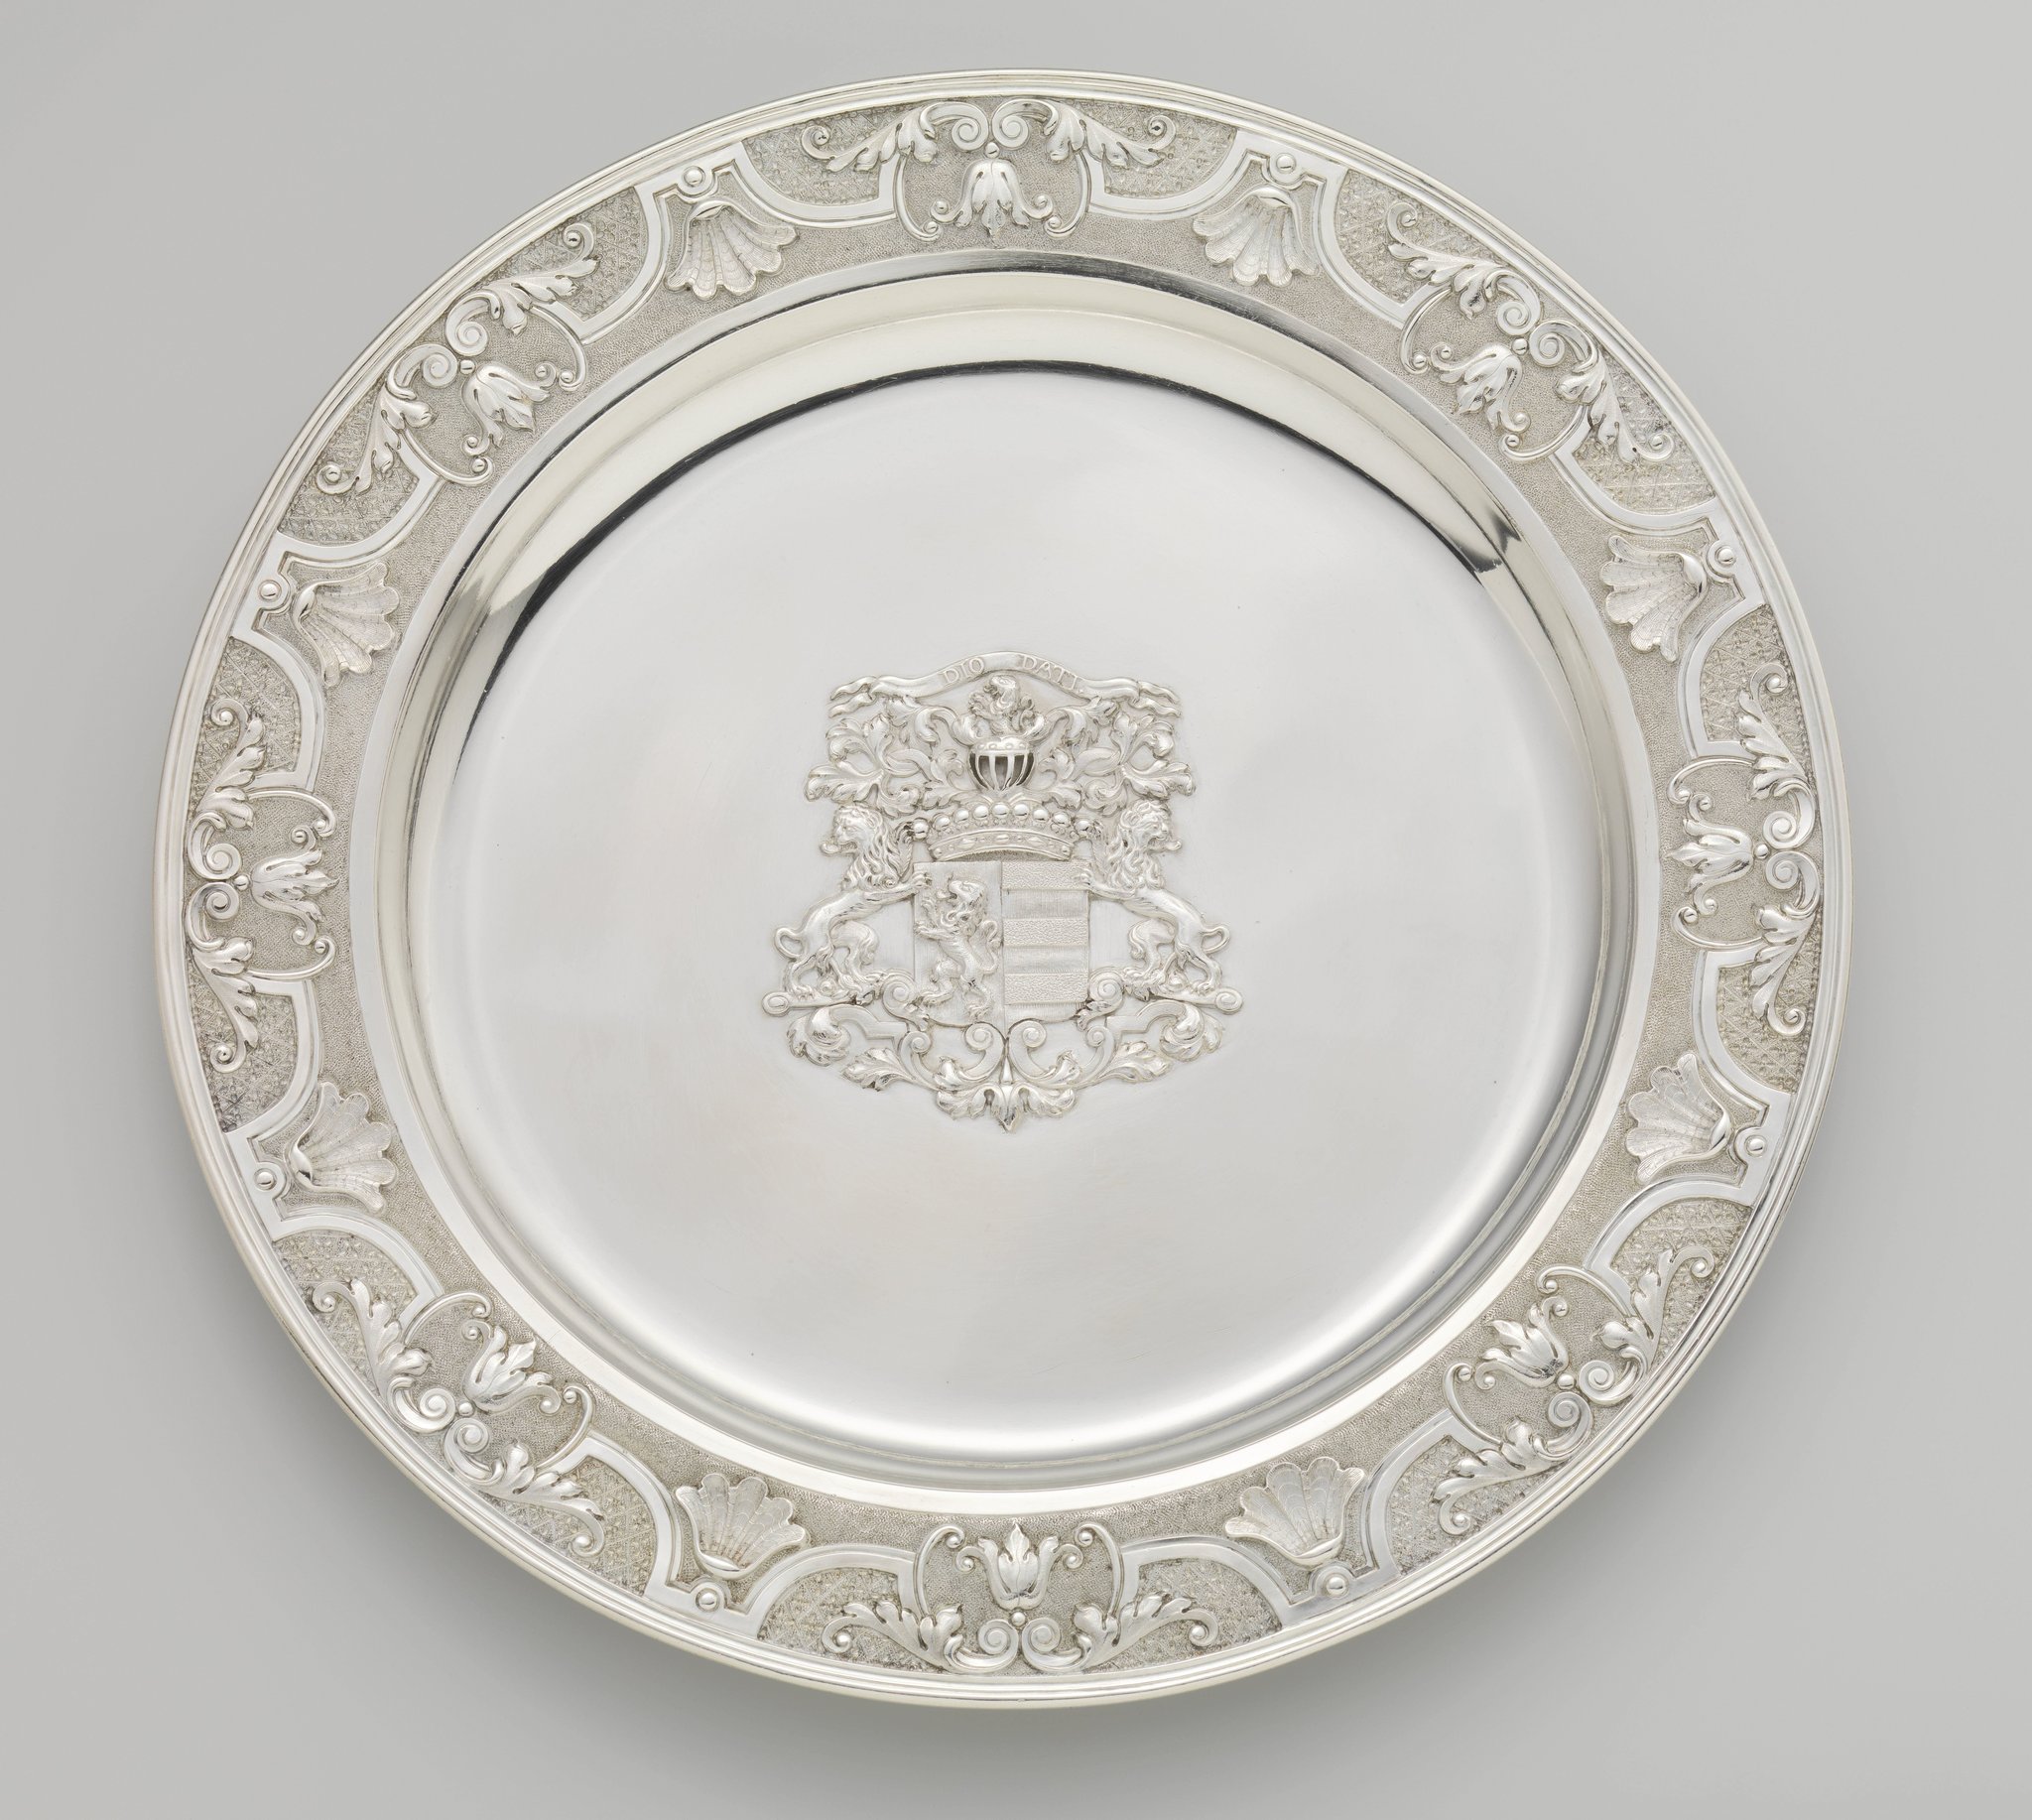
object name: avondmaalsschotel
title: Communion set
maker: dirk wor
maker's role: silversmith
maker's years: 1696-1745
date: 1736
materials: silver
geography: dordrecht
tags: armorial bearing, heraldry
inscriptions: date letter: ‘C’, maker's mark, alloy mark, town mark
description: Central to the Protestant celebration of the Holy Communion is the remembrance of the Last Supper, when Christ and his disciples gathered for the last time. Christ asked that his suffering and death be commemorated with a communal meal. This is why wine is poured into cups and bread is placed on plates during religious services. This communion set from Dordrecht ranks among the most richly decorated altar plate.